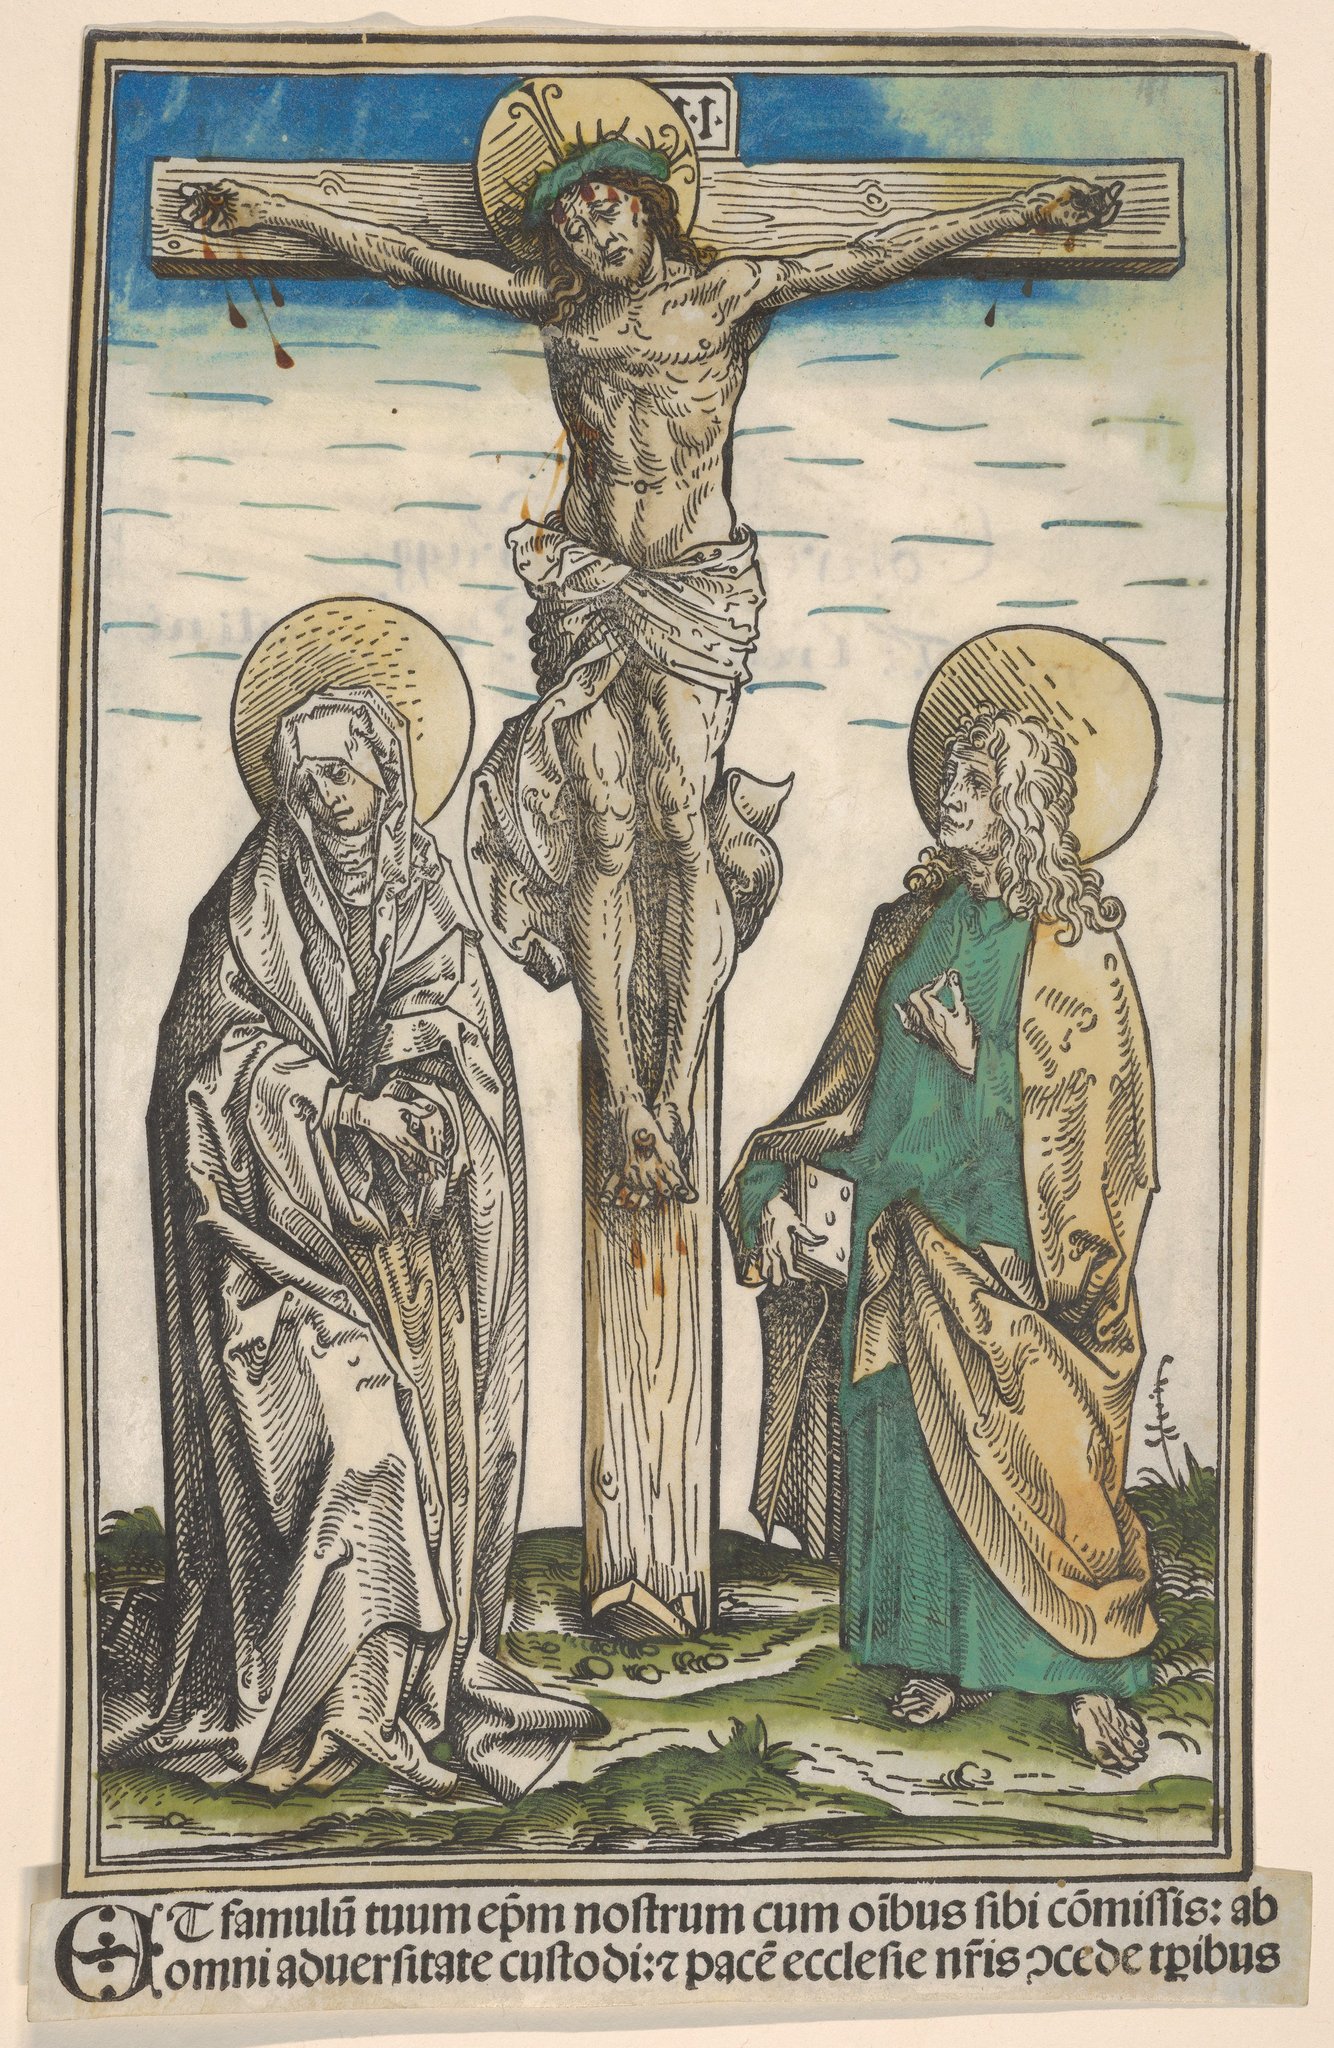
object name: print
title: Christ on the Cross with the Virgin and Saint John, from the Passau Missal (Missale Pataviense)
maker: hans burgkmair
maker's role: artist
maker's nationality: german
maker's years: 1473-1531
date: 1505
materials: parchment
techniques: hand coloring, woodcut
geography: germany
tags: christ,saint john the baptist,virgin mary,crucifixion